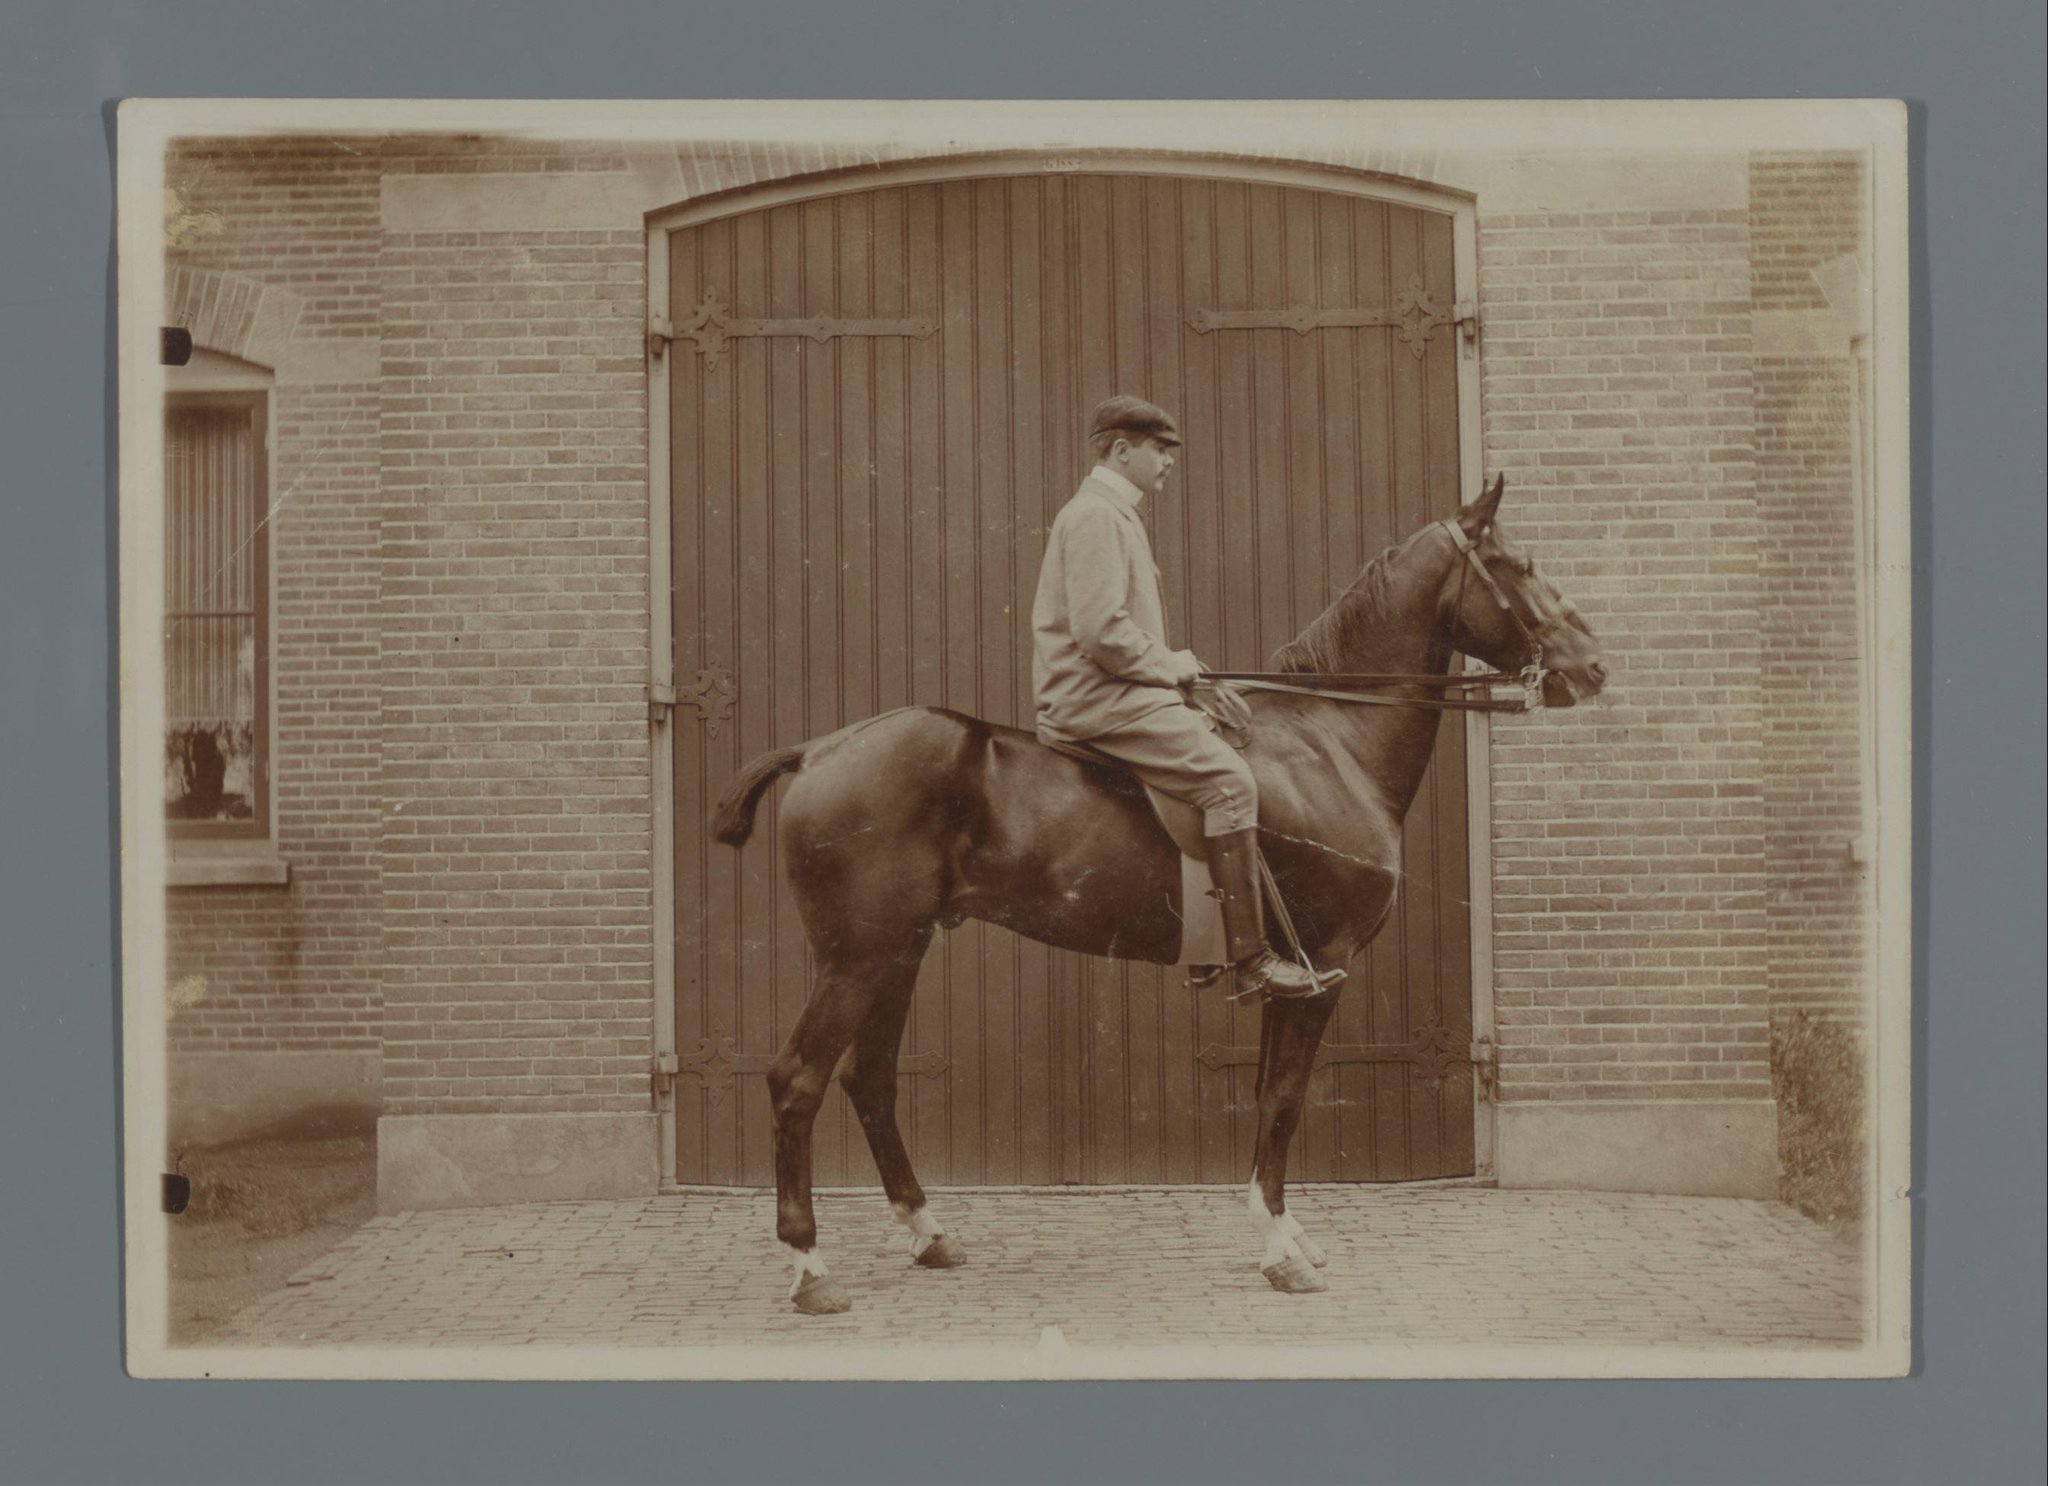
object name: photograph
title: Henk van de Berg op zijn paard Bobbie voor de schuur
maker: hendrik herman van den berg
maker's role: amateurfotograaf, jurist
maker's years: 1875-1944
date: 1896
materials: cardboard, photographic support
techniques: collodion silver print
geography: baarn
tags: rotterdam, amsterdam, norbertus petrus van den berg (1831-1917), riding a horse, ass, or mule; rider, horseman